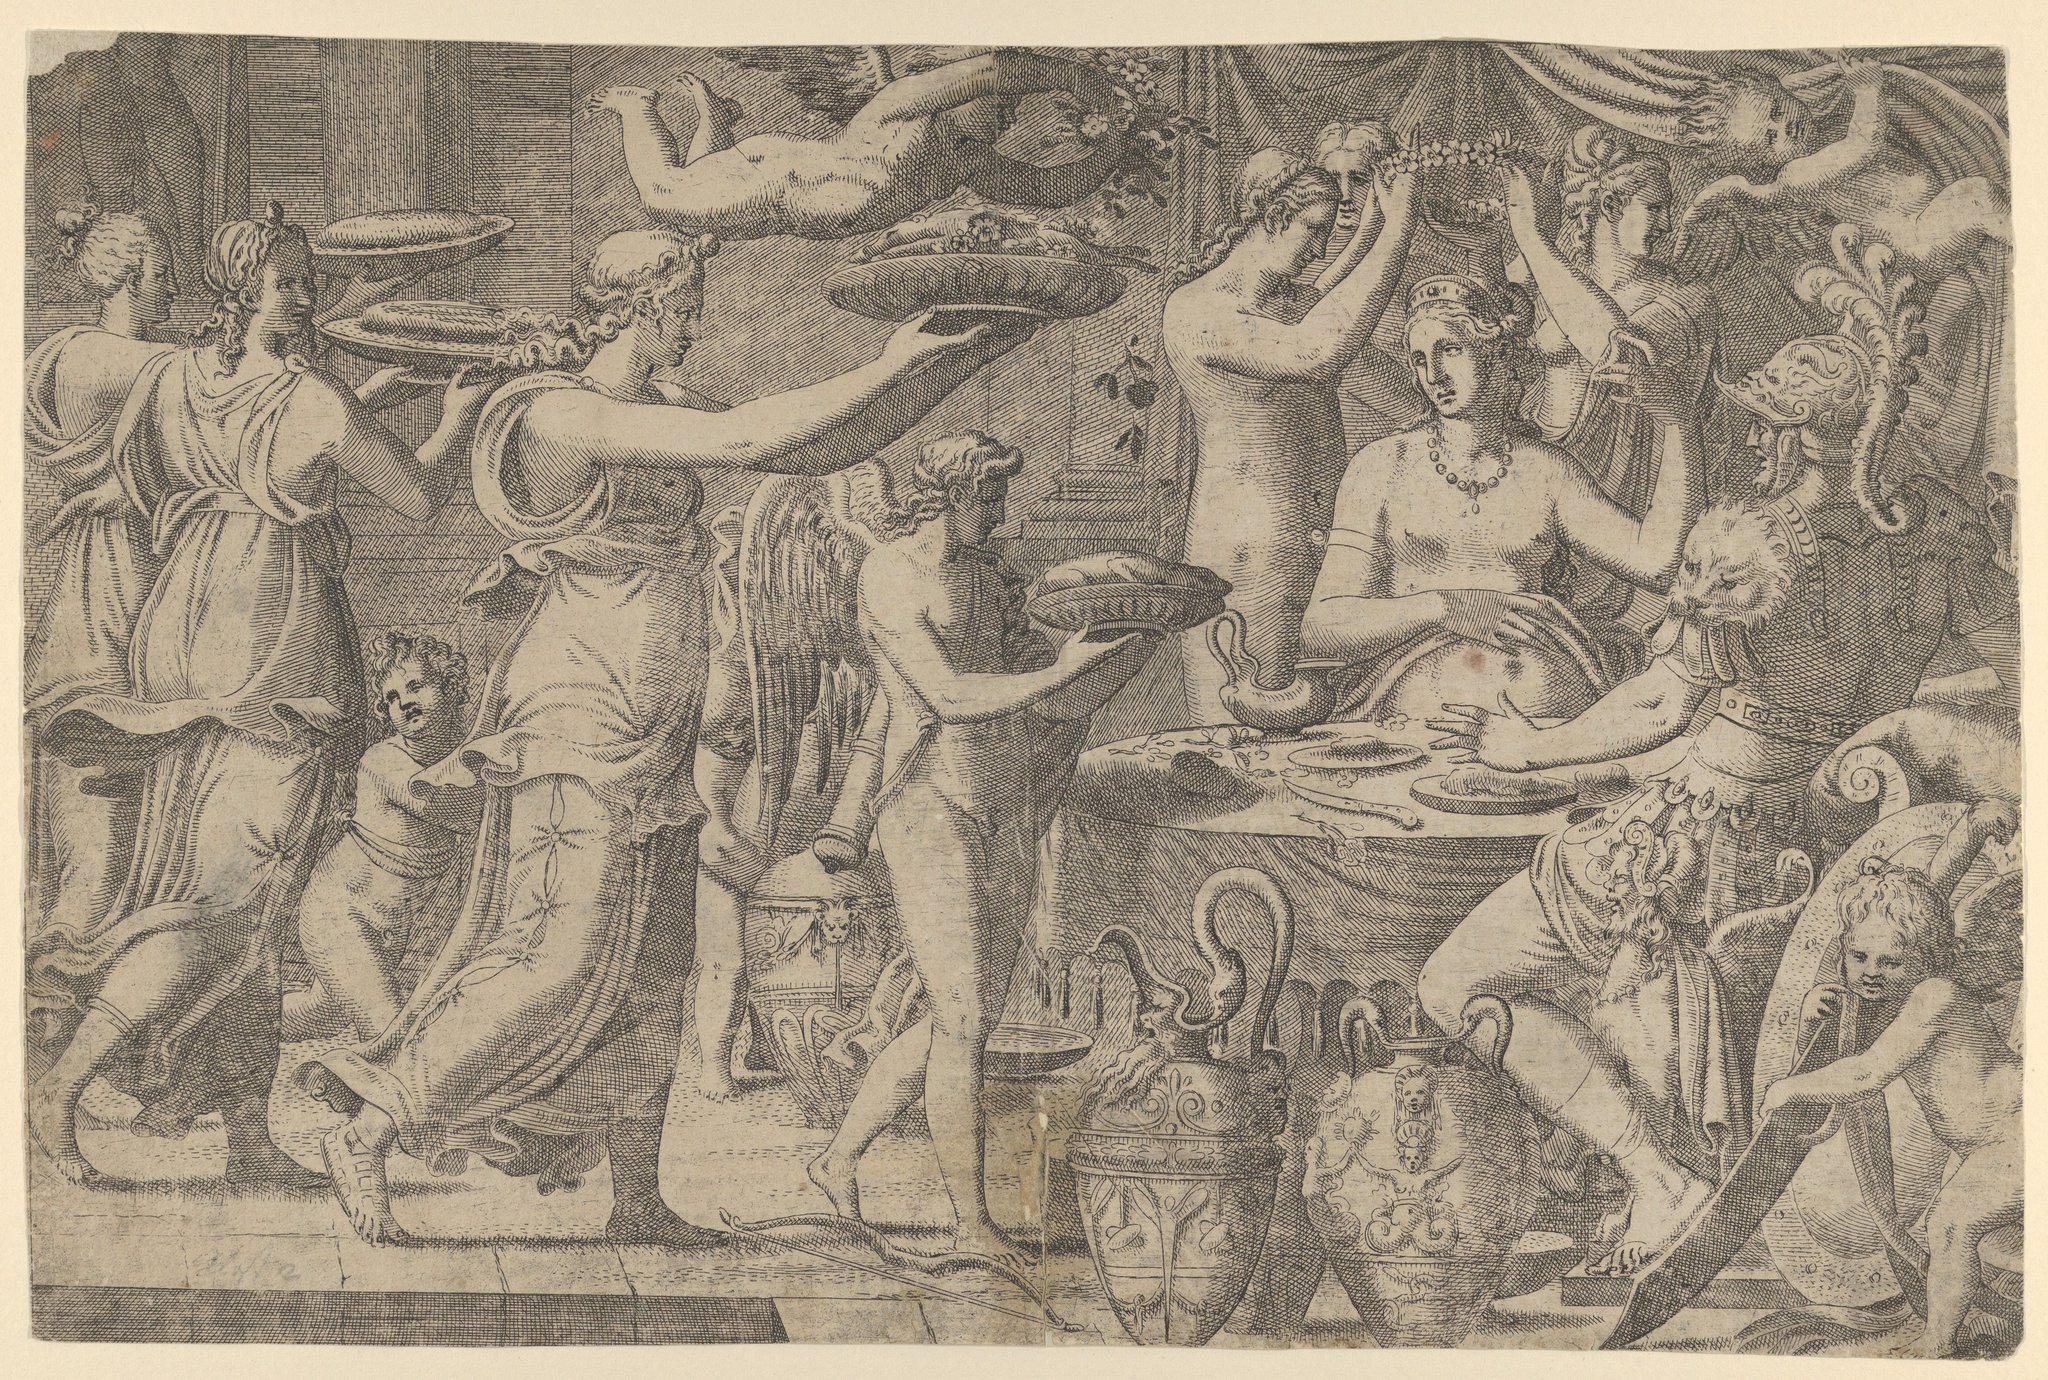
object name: print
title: Mars and Venus Served by Cupid and the Graces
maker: léon davent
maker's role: artist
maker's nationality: french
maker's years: 1540-1556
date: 1545-1550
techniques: engraving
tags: cupid,mars,venus